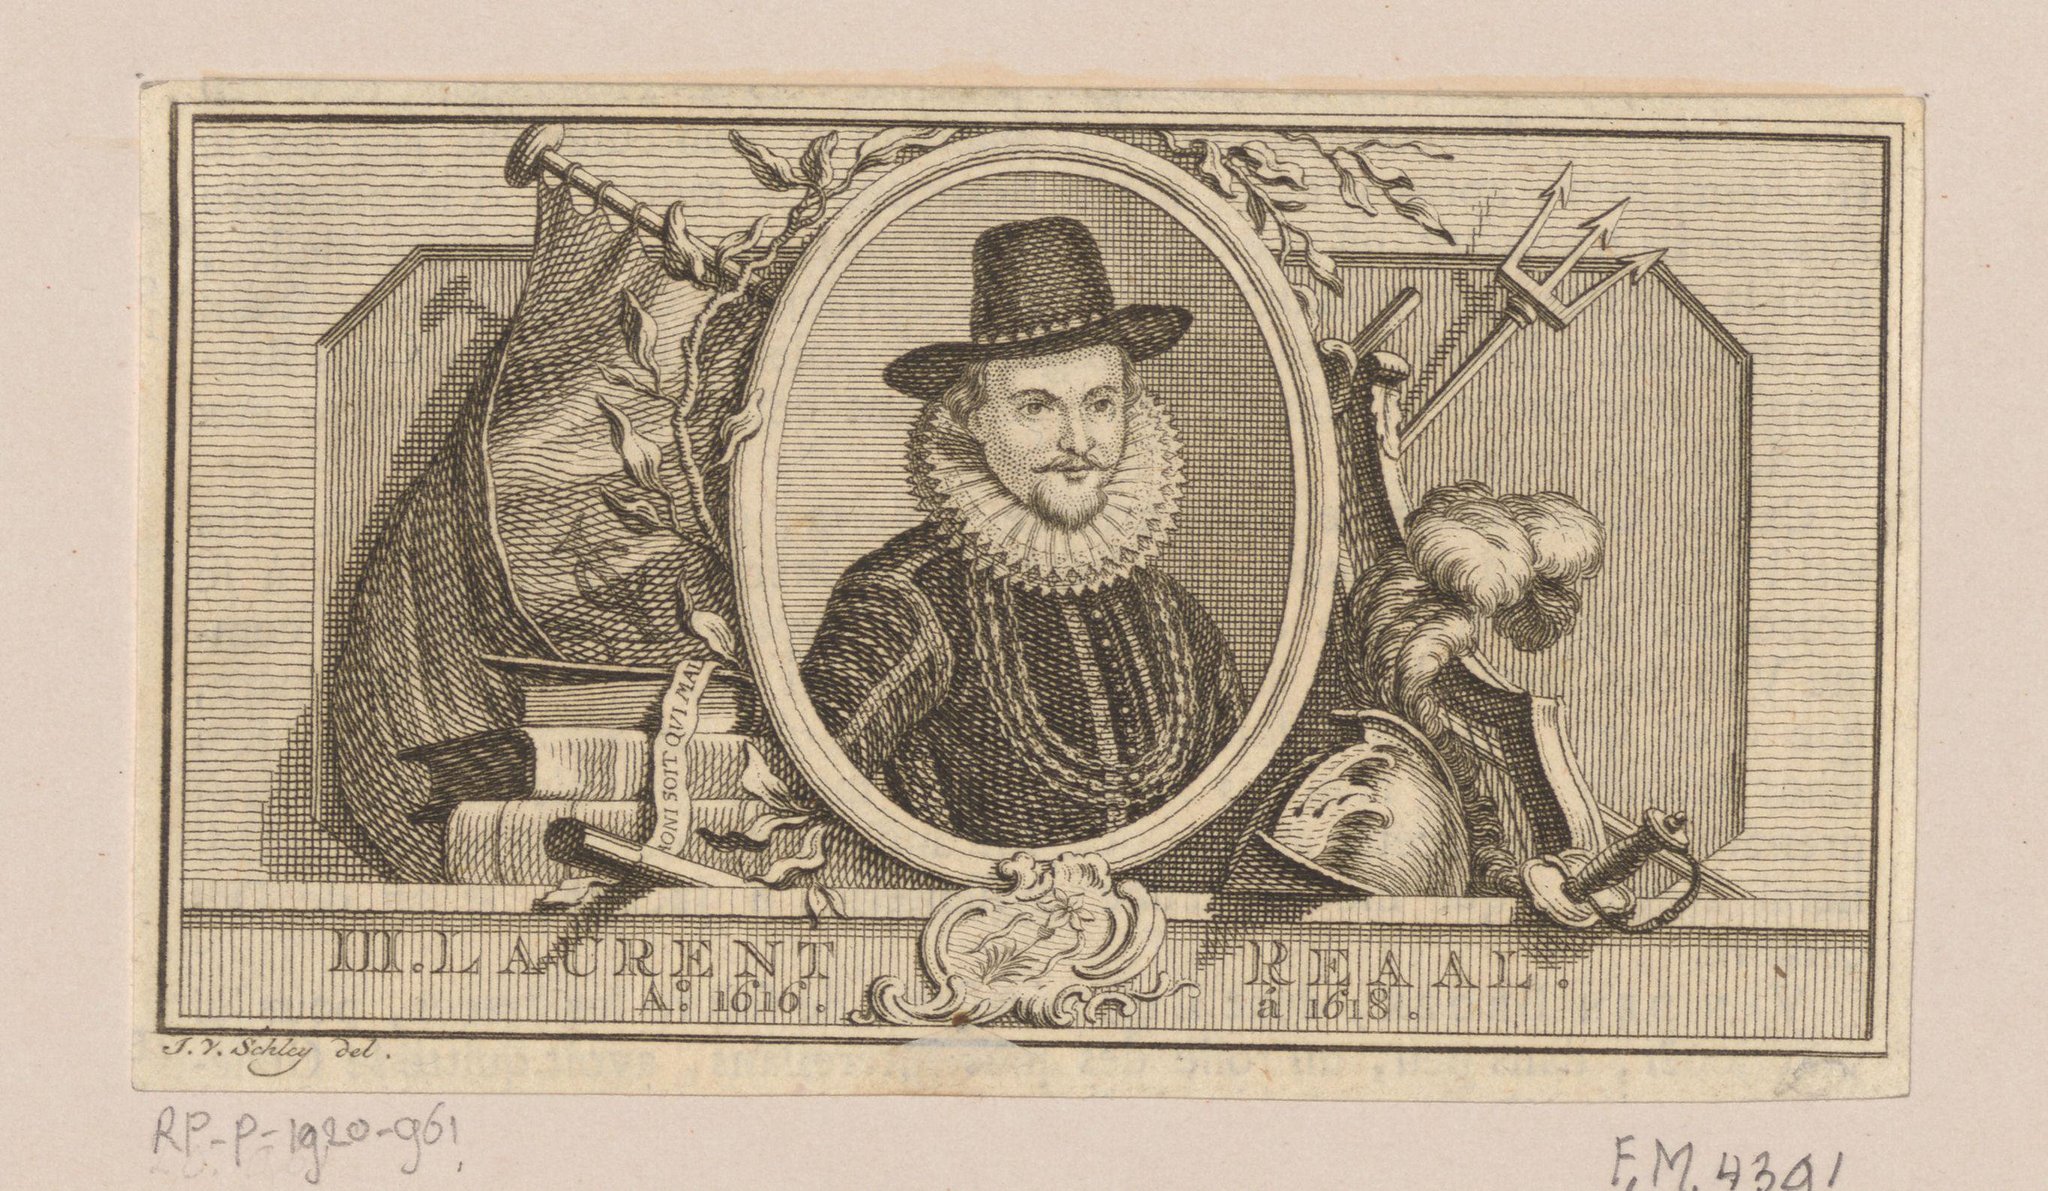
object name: book illustration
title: Portret van Laurens Reael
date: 1763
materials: paper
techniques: etching, letterpress printing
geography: the hague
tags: laurens reael, helmet, historical persons, book, attributes of neptune: trident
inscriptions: collector's mark: Lugt 2228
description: Prent uit: Bois, J.P.L. du. Vies des gouverneurs généraux (...). Den Haag: Pieter de Hondt, 1763.